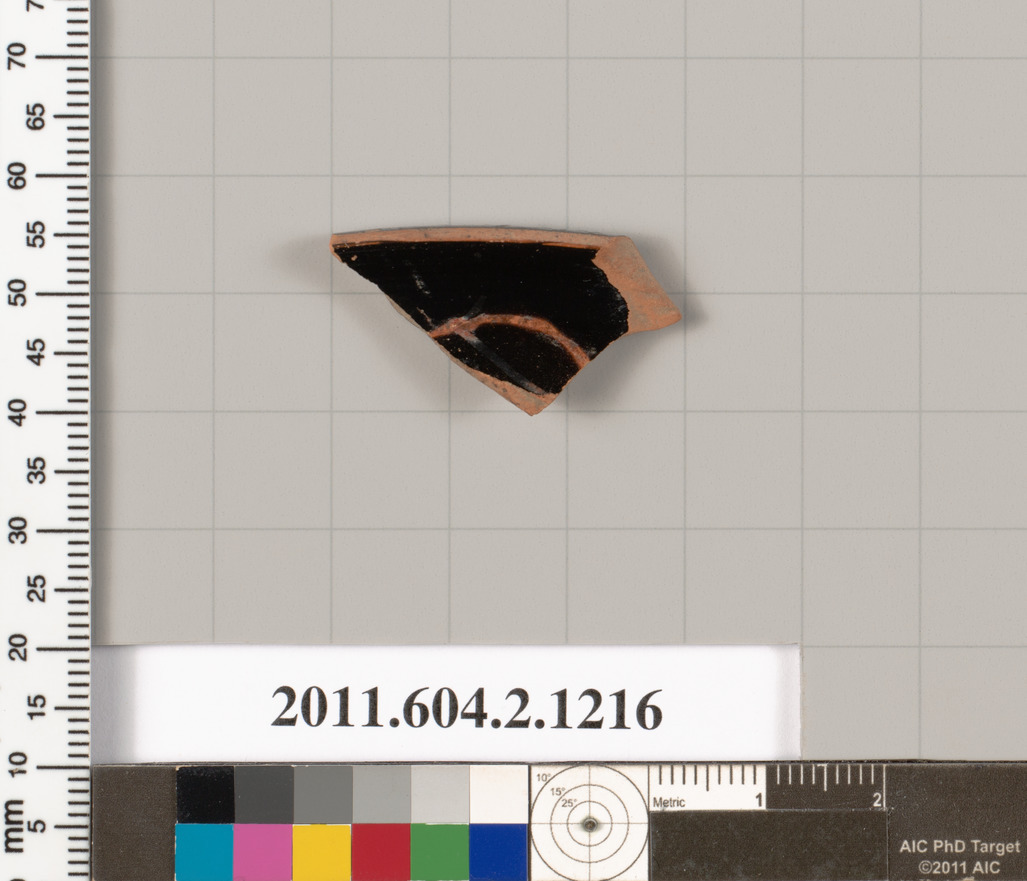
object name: kantharos fragment, head vase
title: Terracotta fragment from a kantharos: head vase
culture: greek, attic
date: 475-451 BCE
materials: terracotta